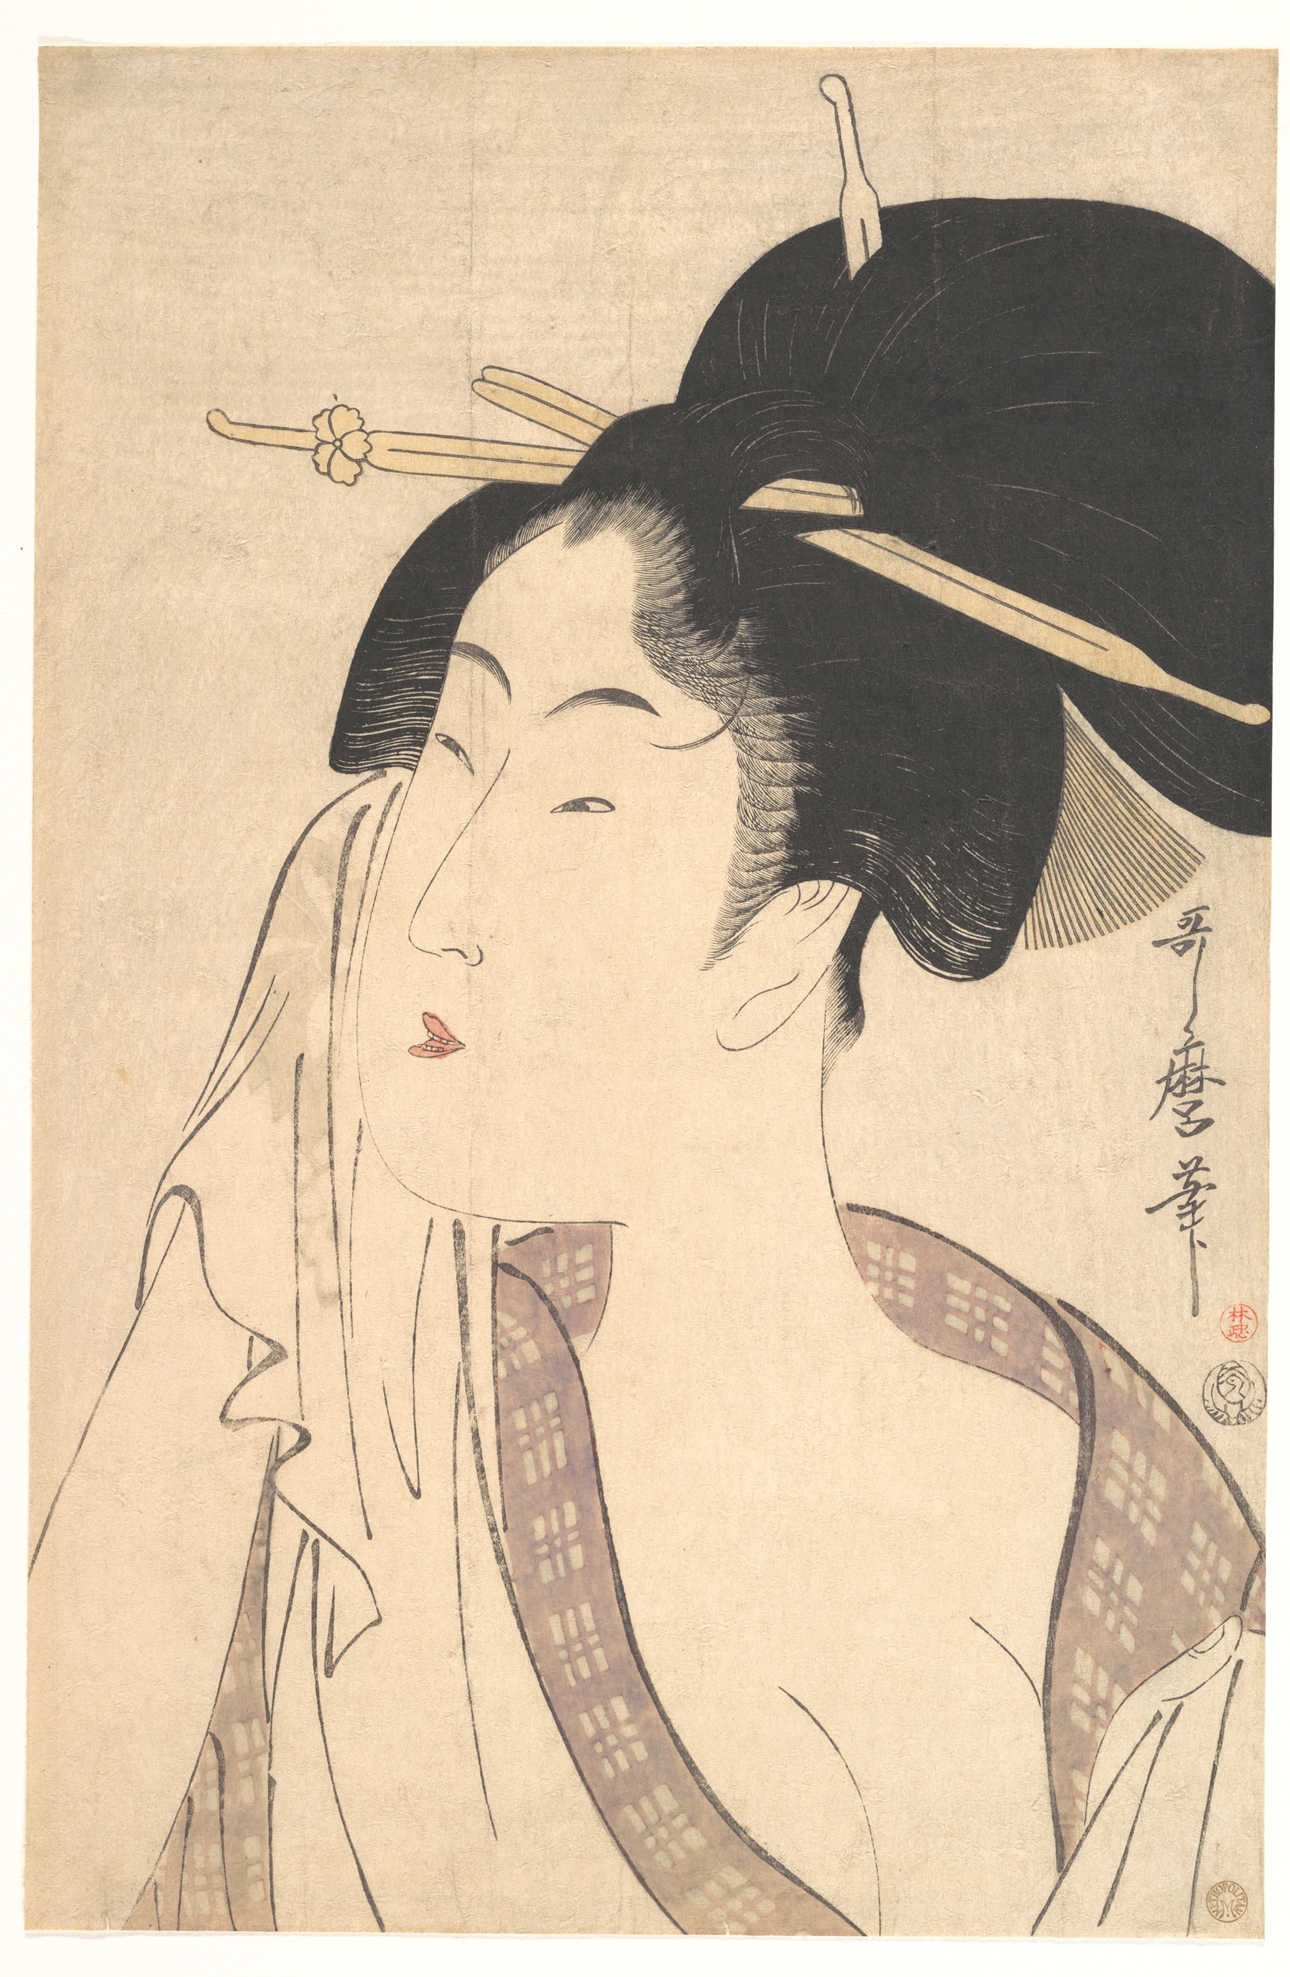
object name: print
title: Woman Relaxing after Her Bath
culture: japanese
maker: kitagawa utamaro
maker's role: artist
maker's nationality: japanese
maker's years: 1754-1806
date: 1790-1799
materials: ink, paper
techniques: woodblock print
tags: women